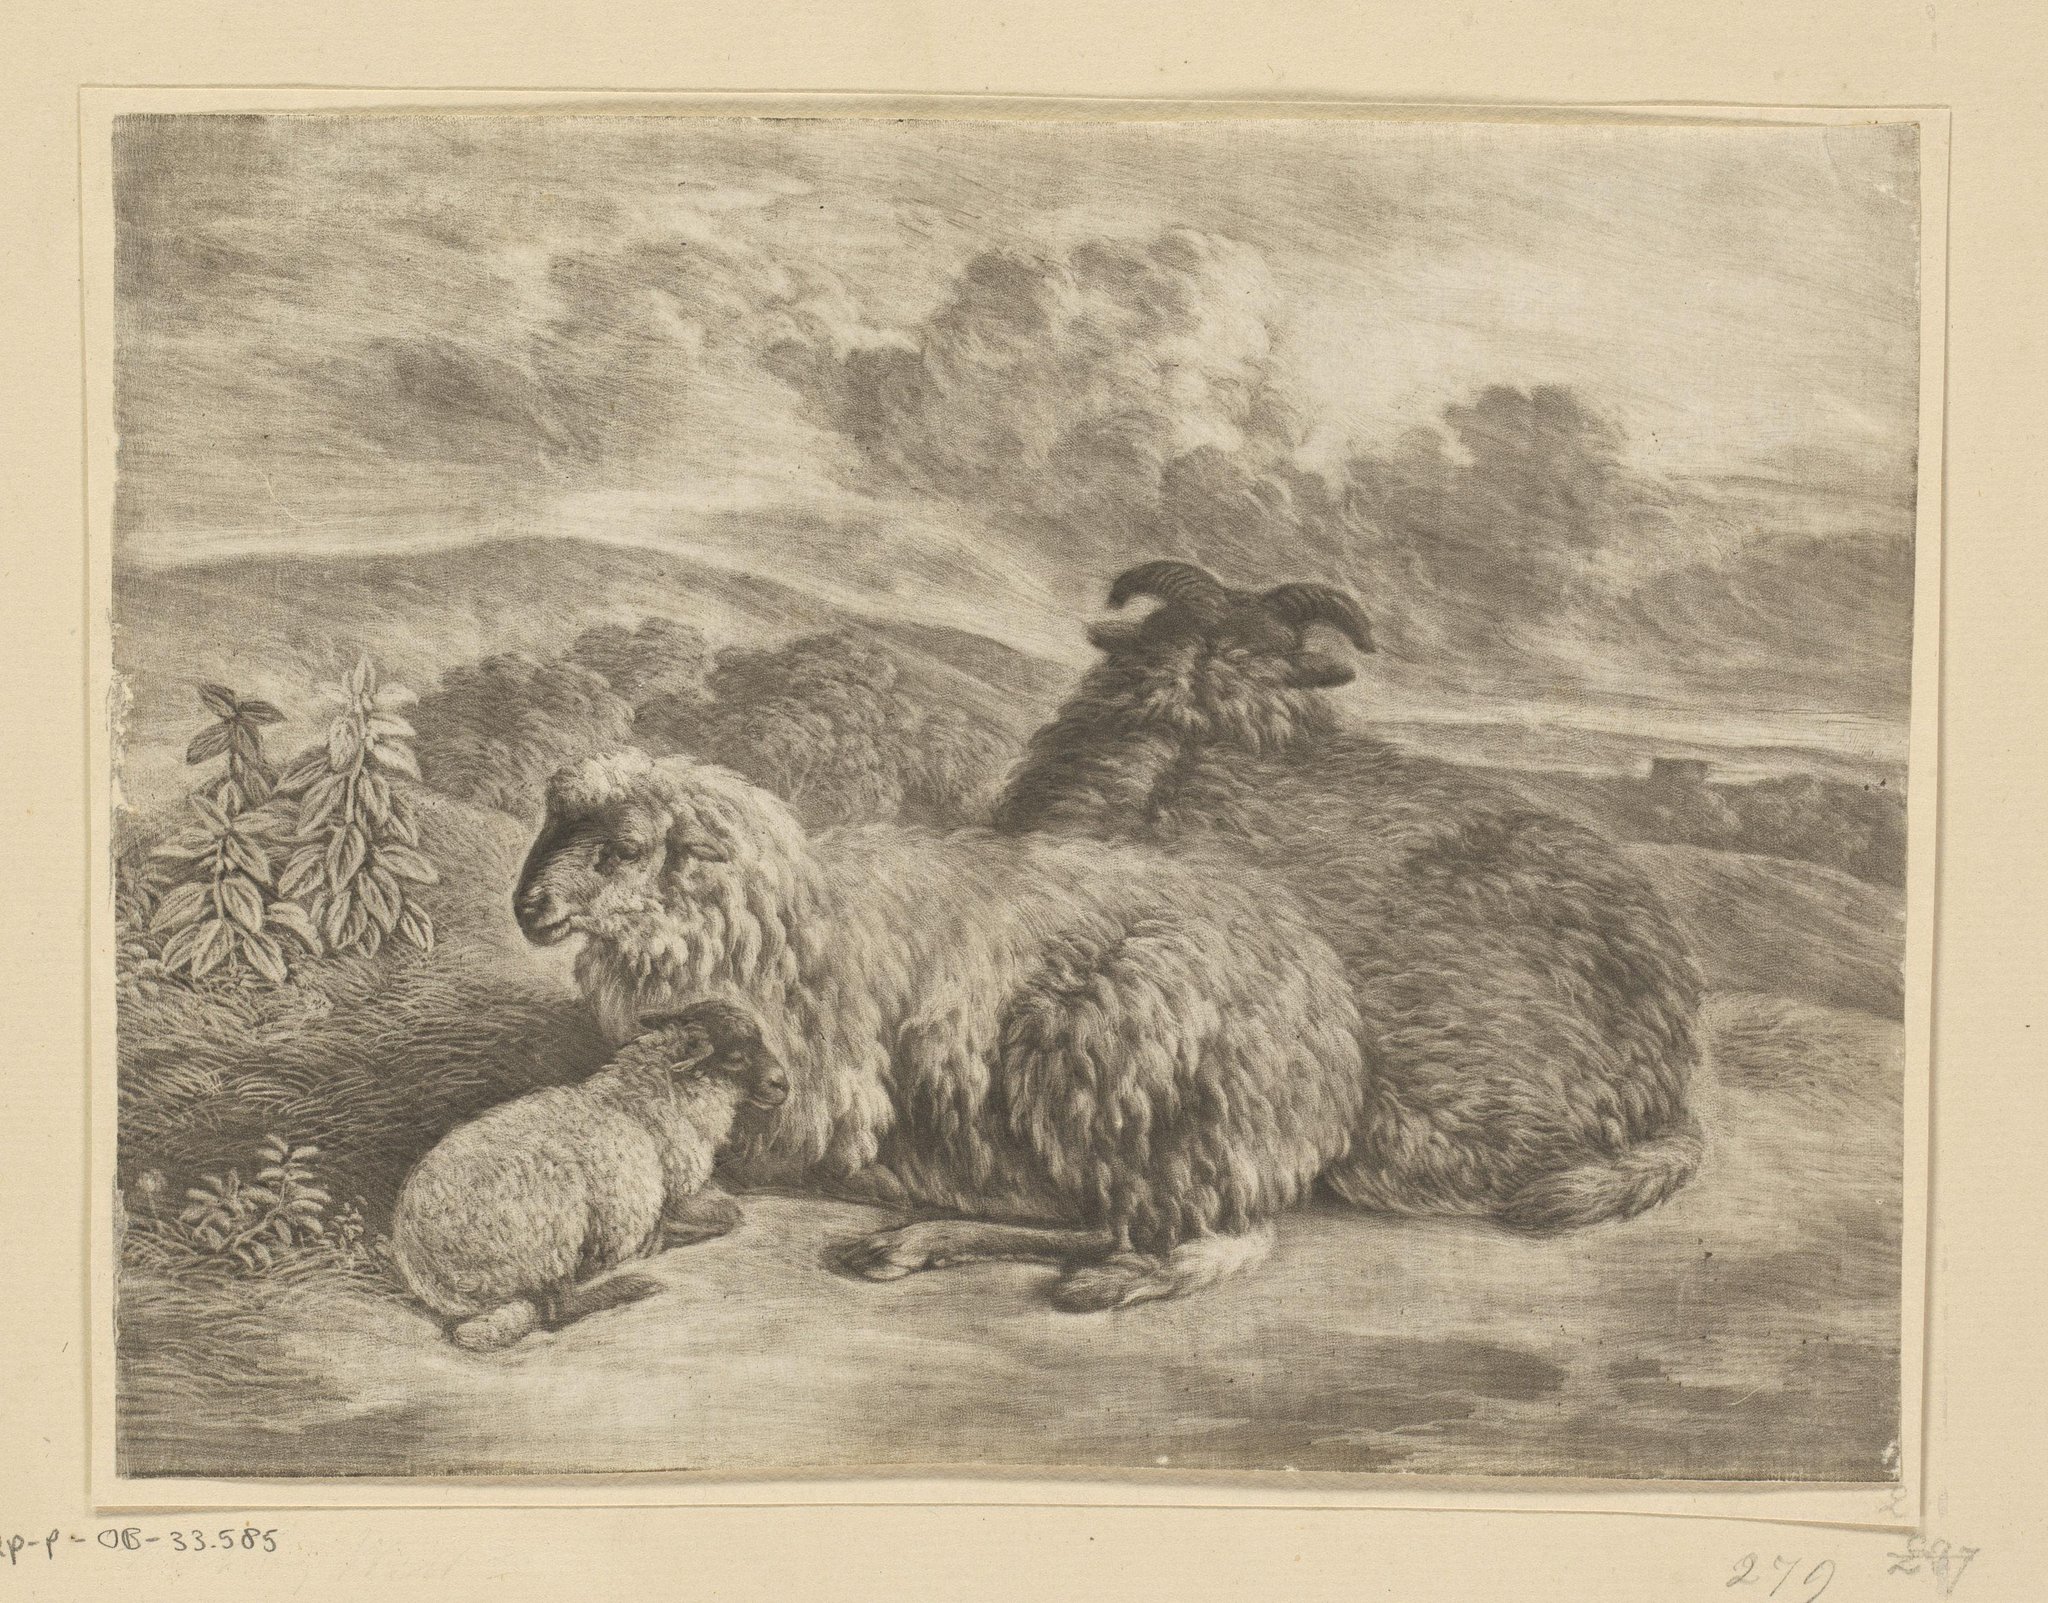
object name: print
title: Twee liggende schapen met lam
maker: Anonymous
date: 1680-1720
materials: paper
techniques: mezzotint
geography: england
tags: ram, lamb, ewe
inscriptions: collector's mark: Lugt 240